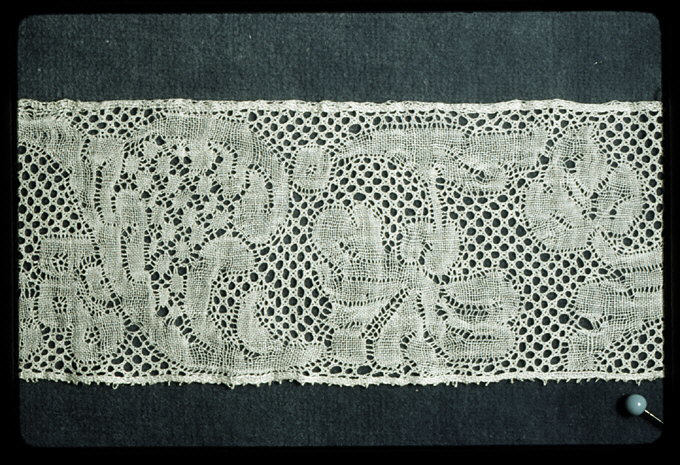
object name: strip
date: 1860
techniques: lace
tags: flowers